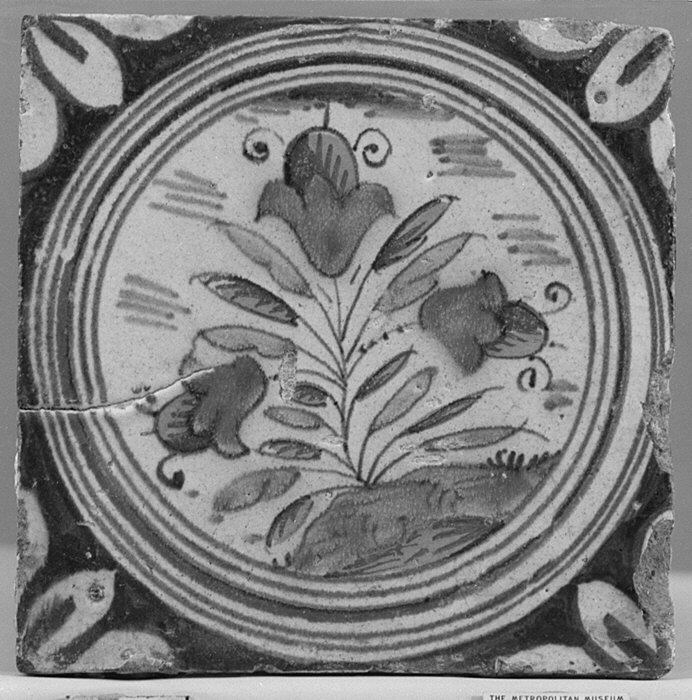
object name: tile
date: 1580-1620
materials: earthenware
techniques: glazing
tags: flowers